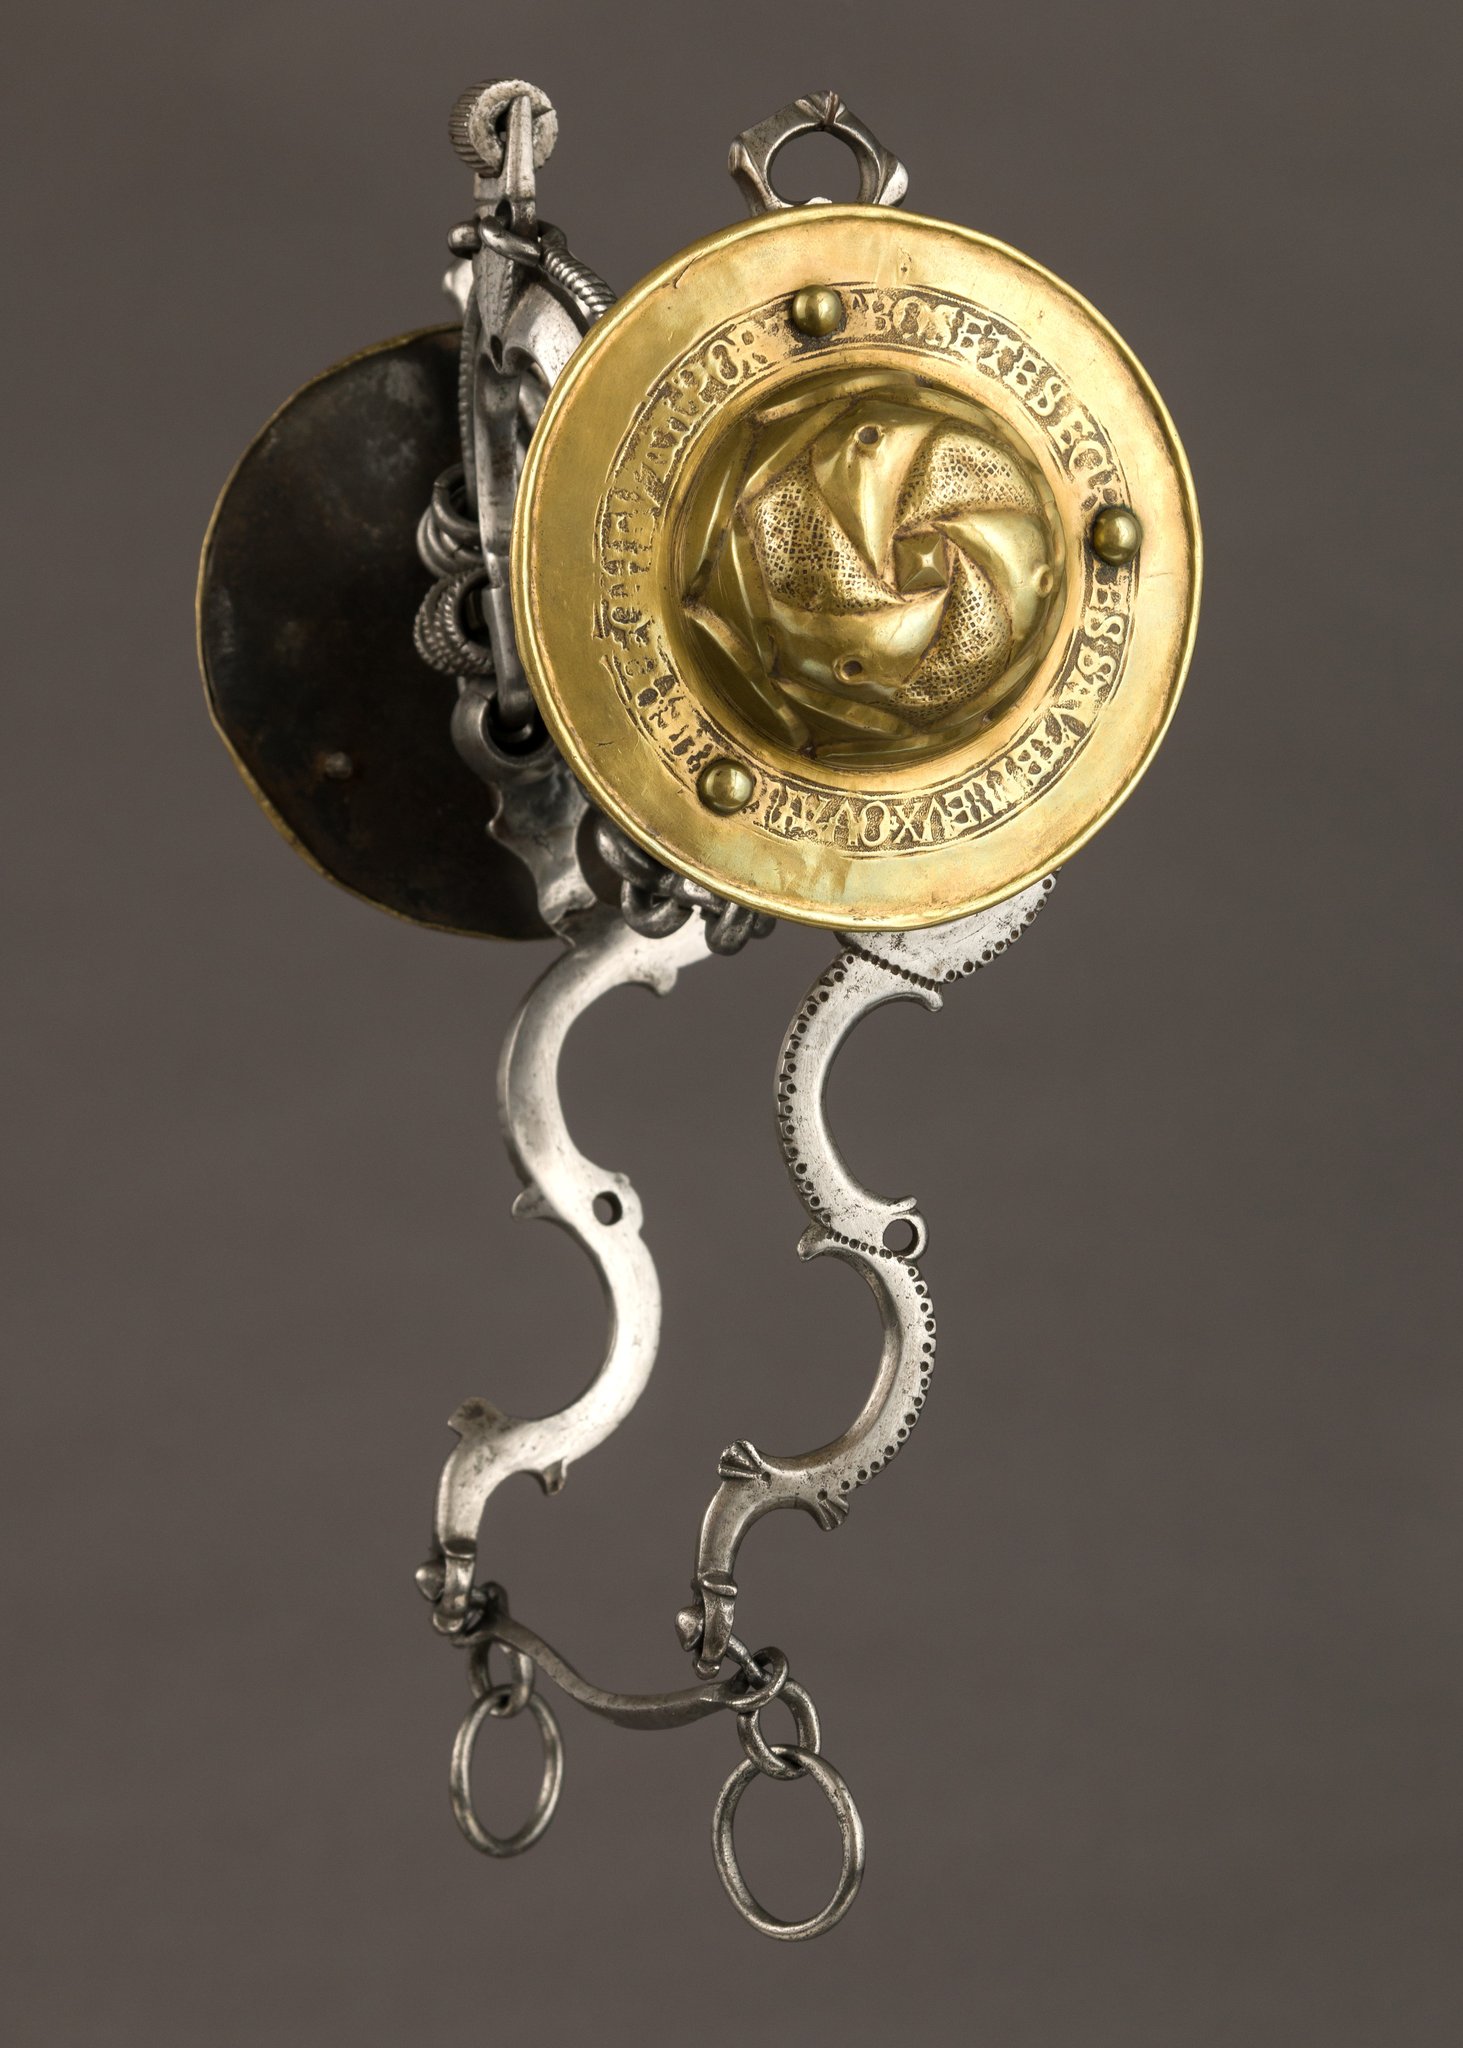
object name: bit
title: Curb Bit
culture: bit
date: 1530-1550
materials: copper alloy, metal alloy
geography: south netherlands